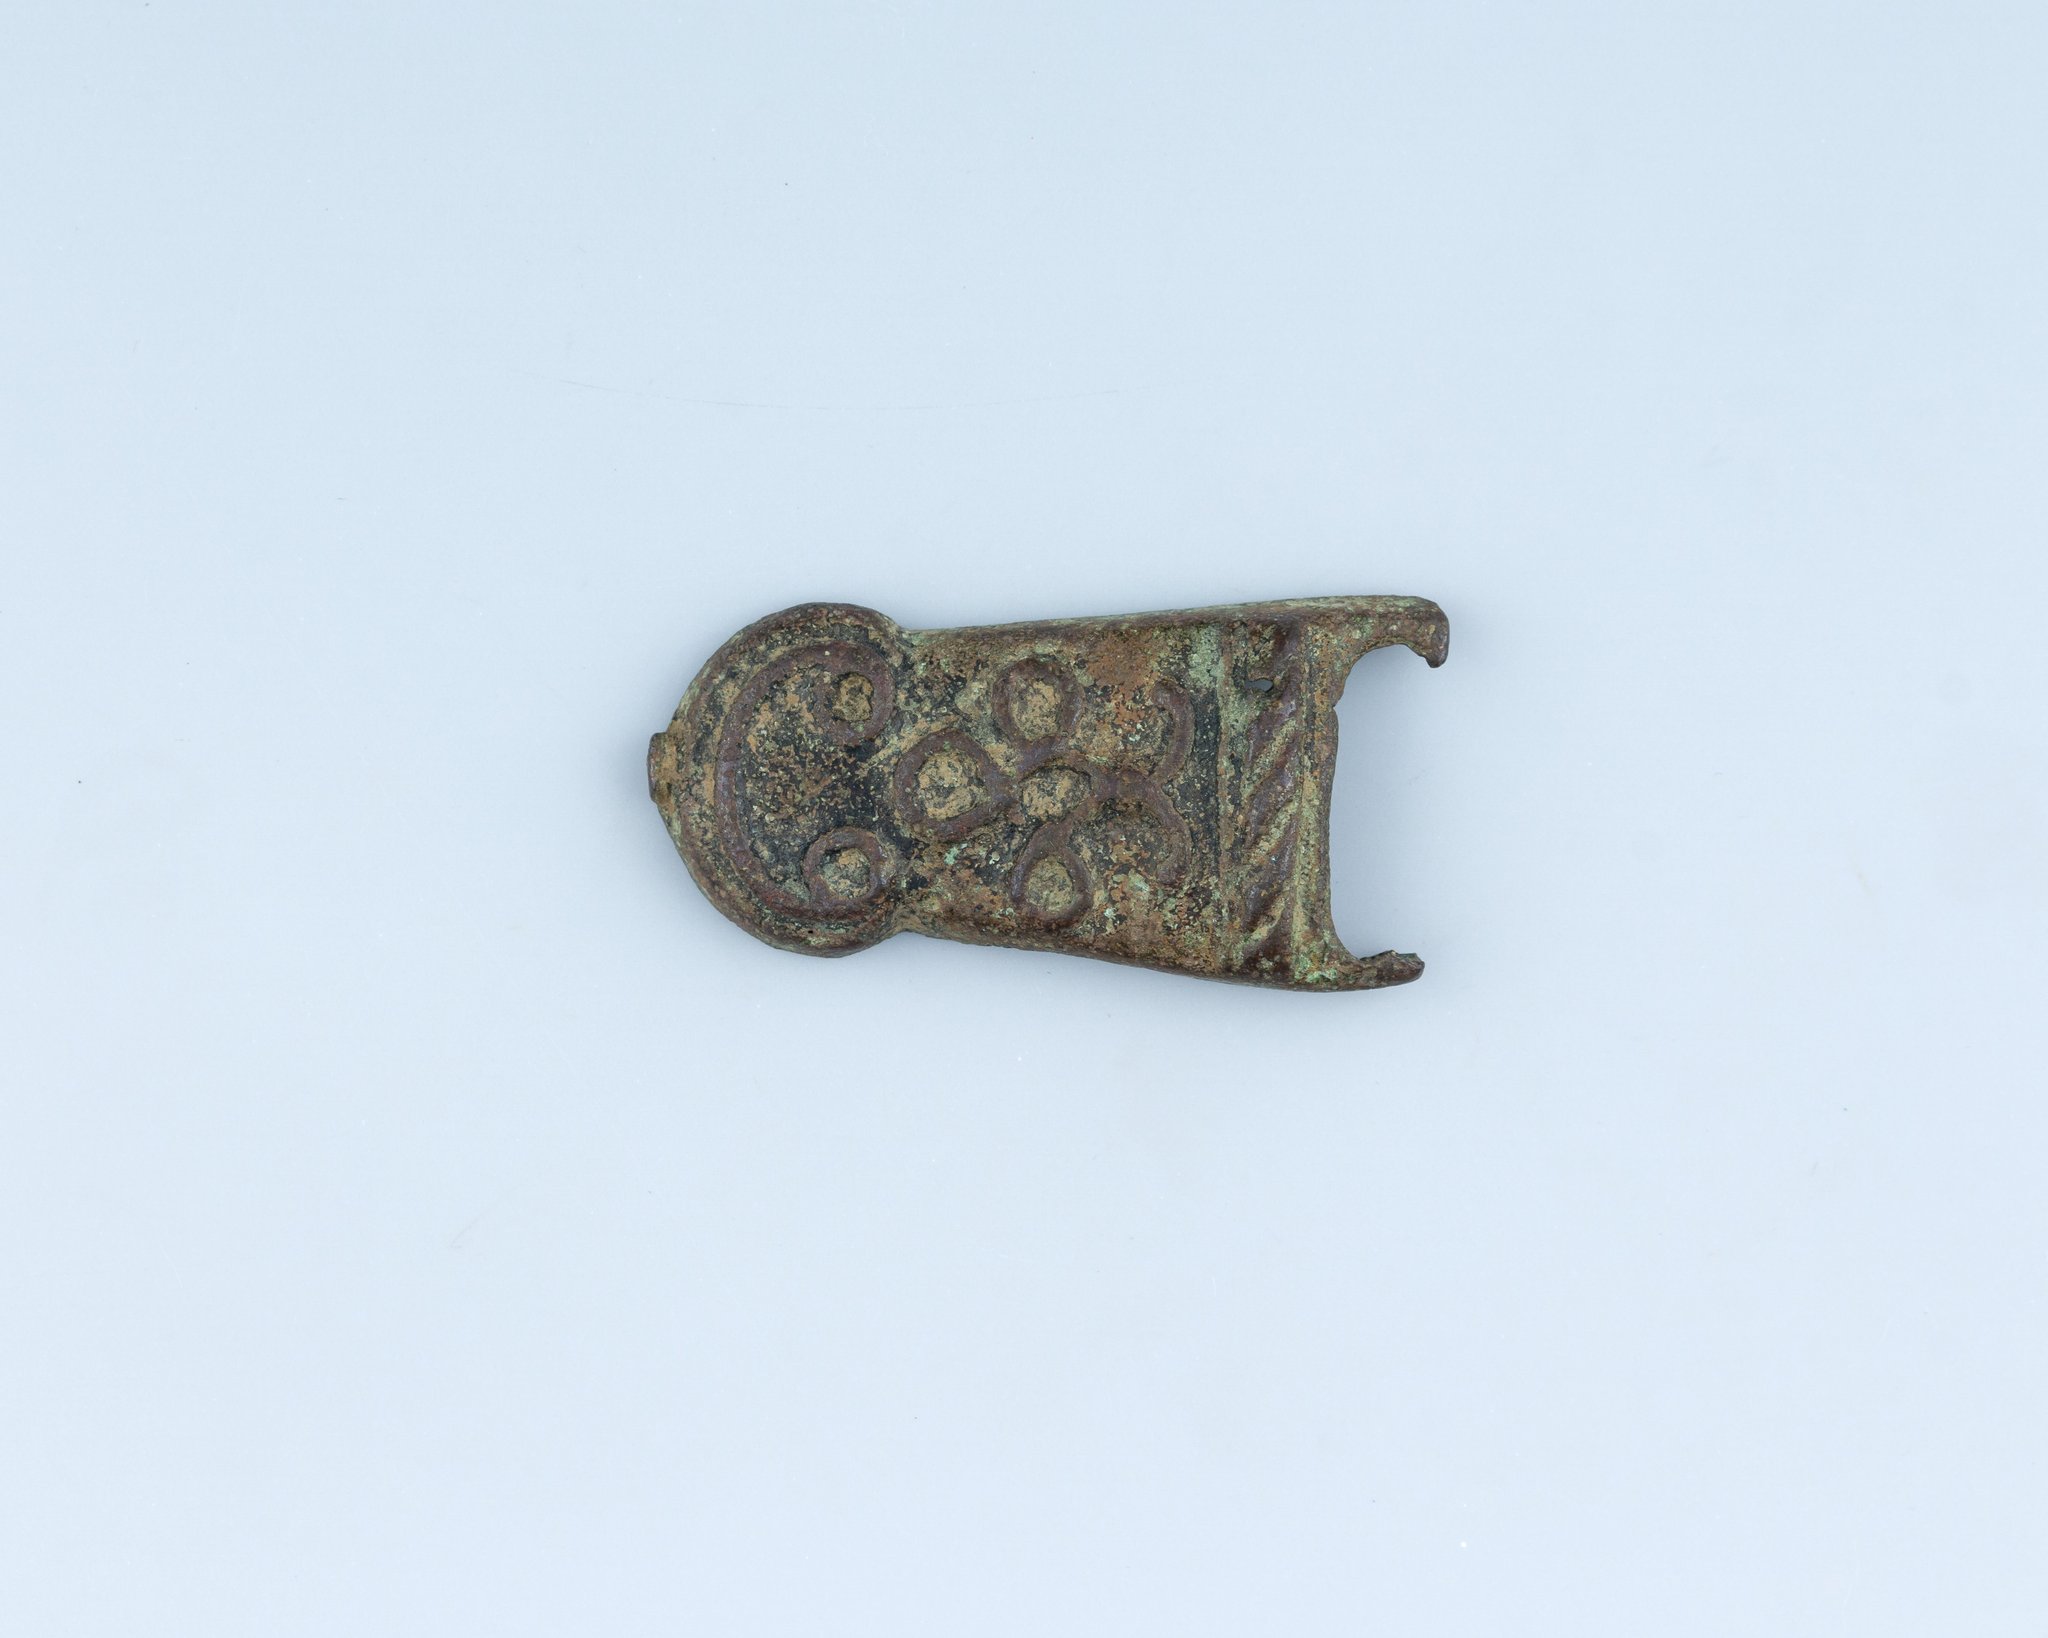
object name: mordant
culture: european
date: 1401-1700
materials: bronze